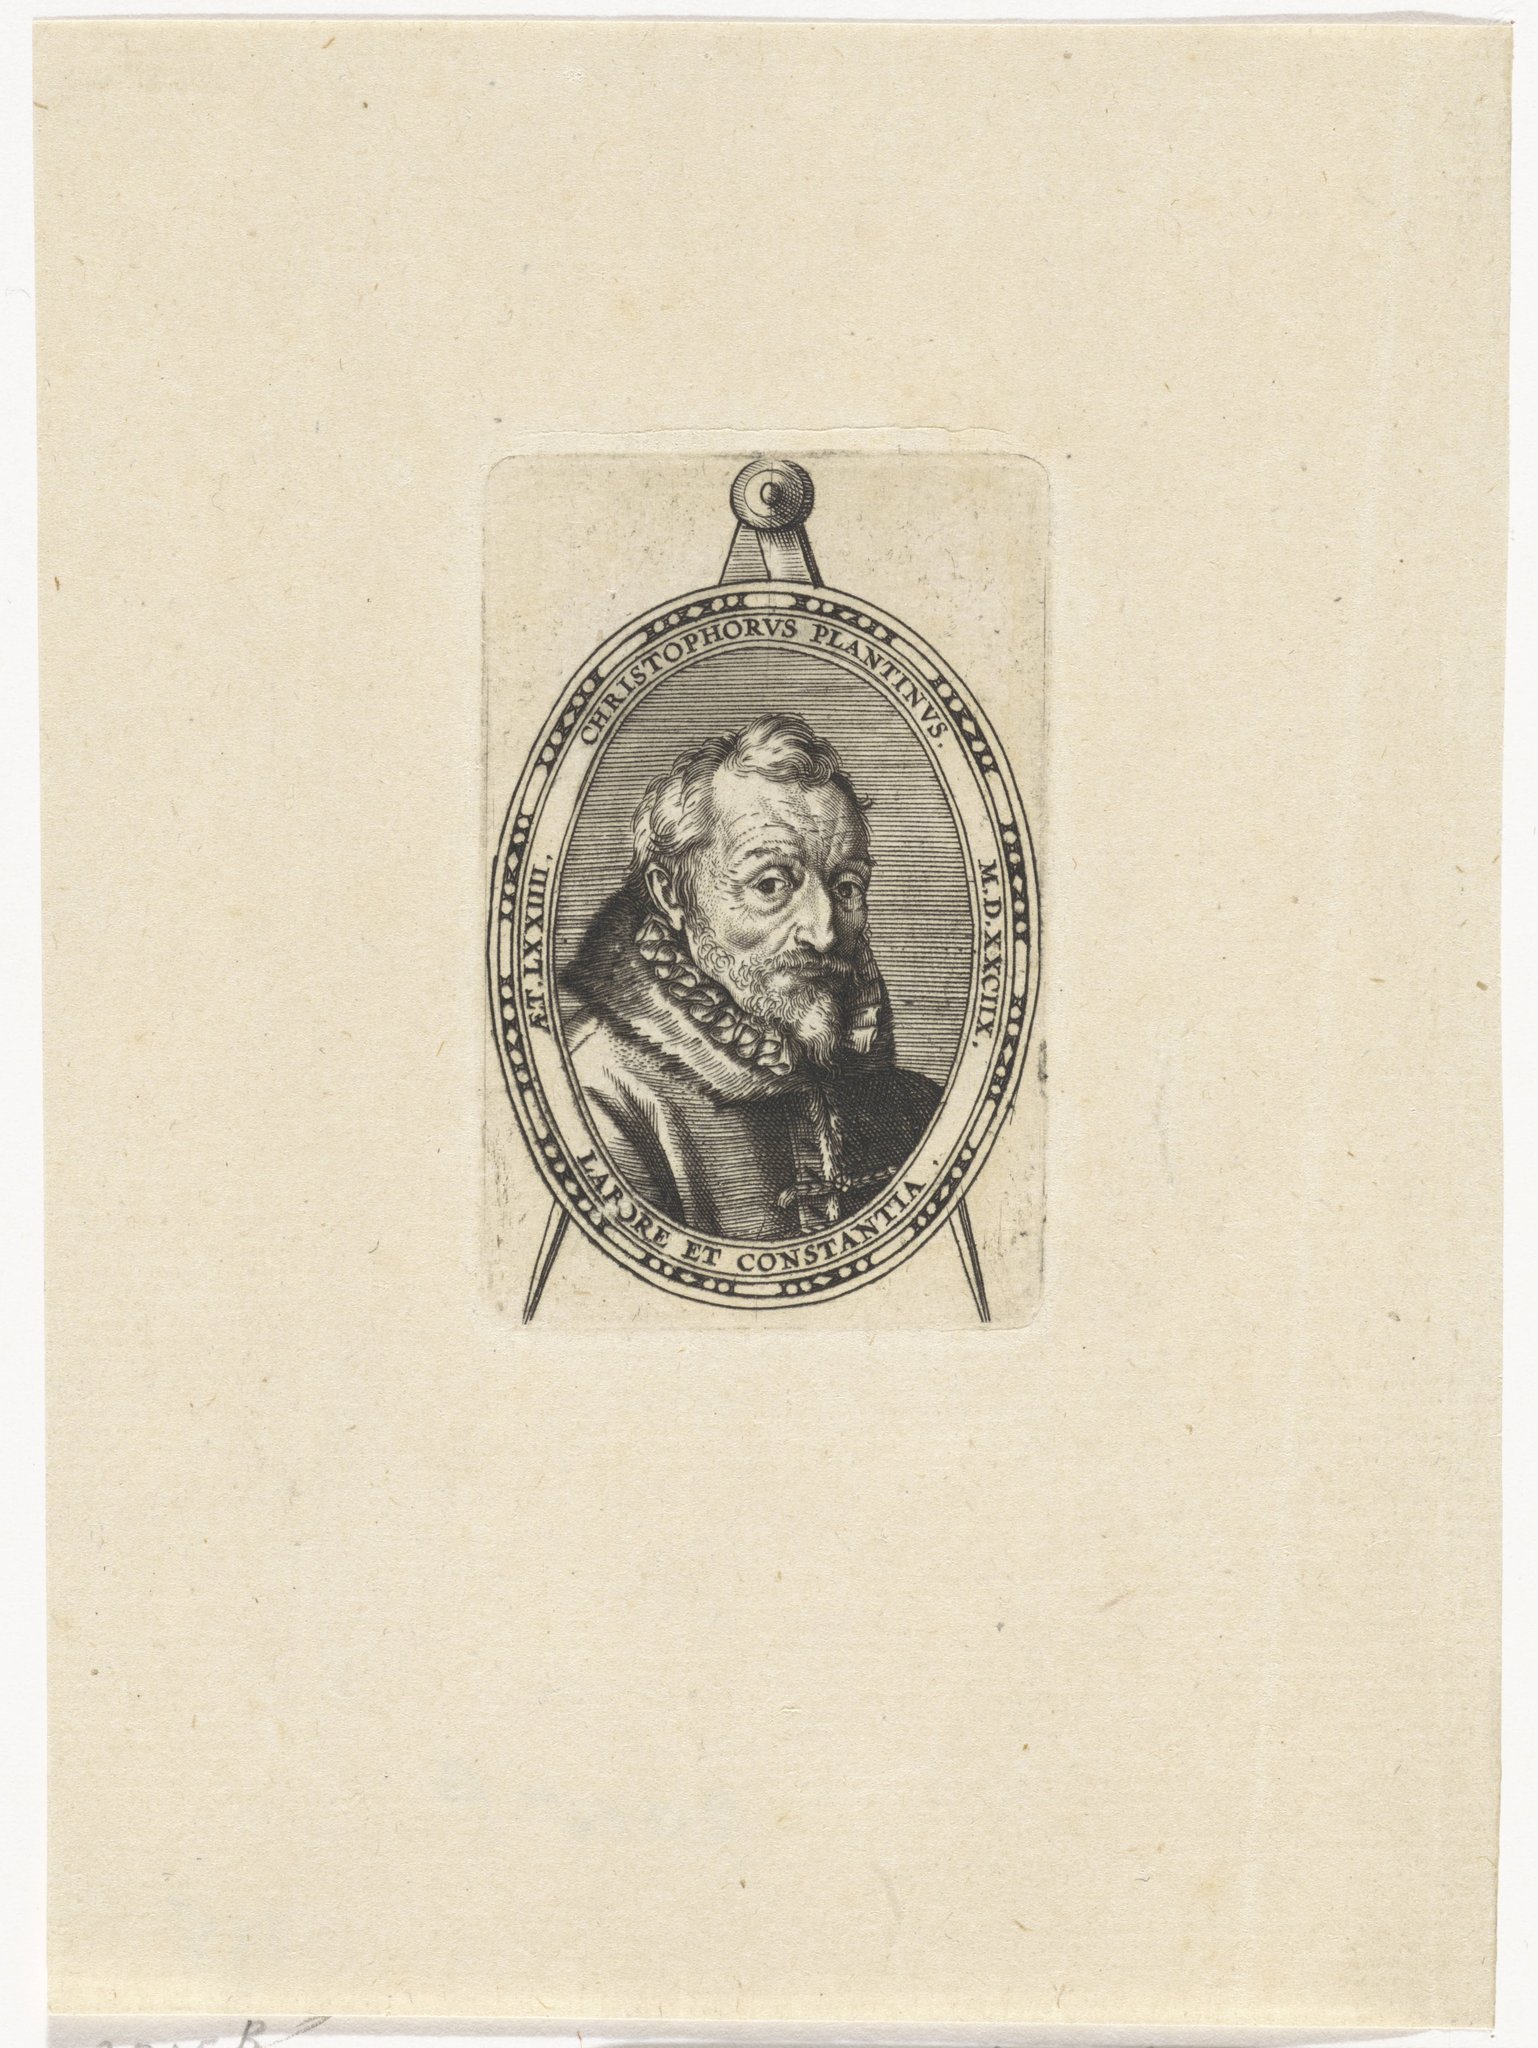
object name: print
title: Portret van de uitgever Christoffel Plantijn, op 74-jarige leeftijd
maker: Anonymous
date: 1588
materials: paper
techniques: engraving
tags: publisher, christoffel plantijn, compasses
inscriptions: collector's mark: Lugt 2228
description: Zijn portret is gevat in een ovale omijsting met daarachter een passer.